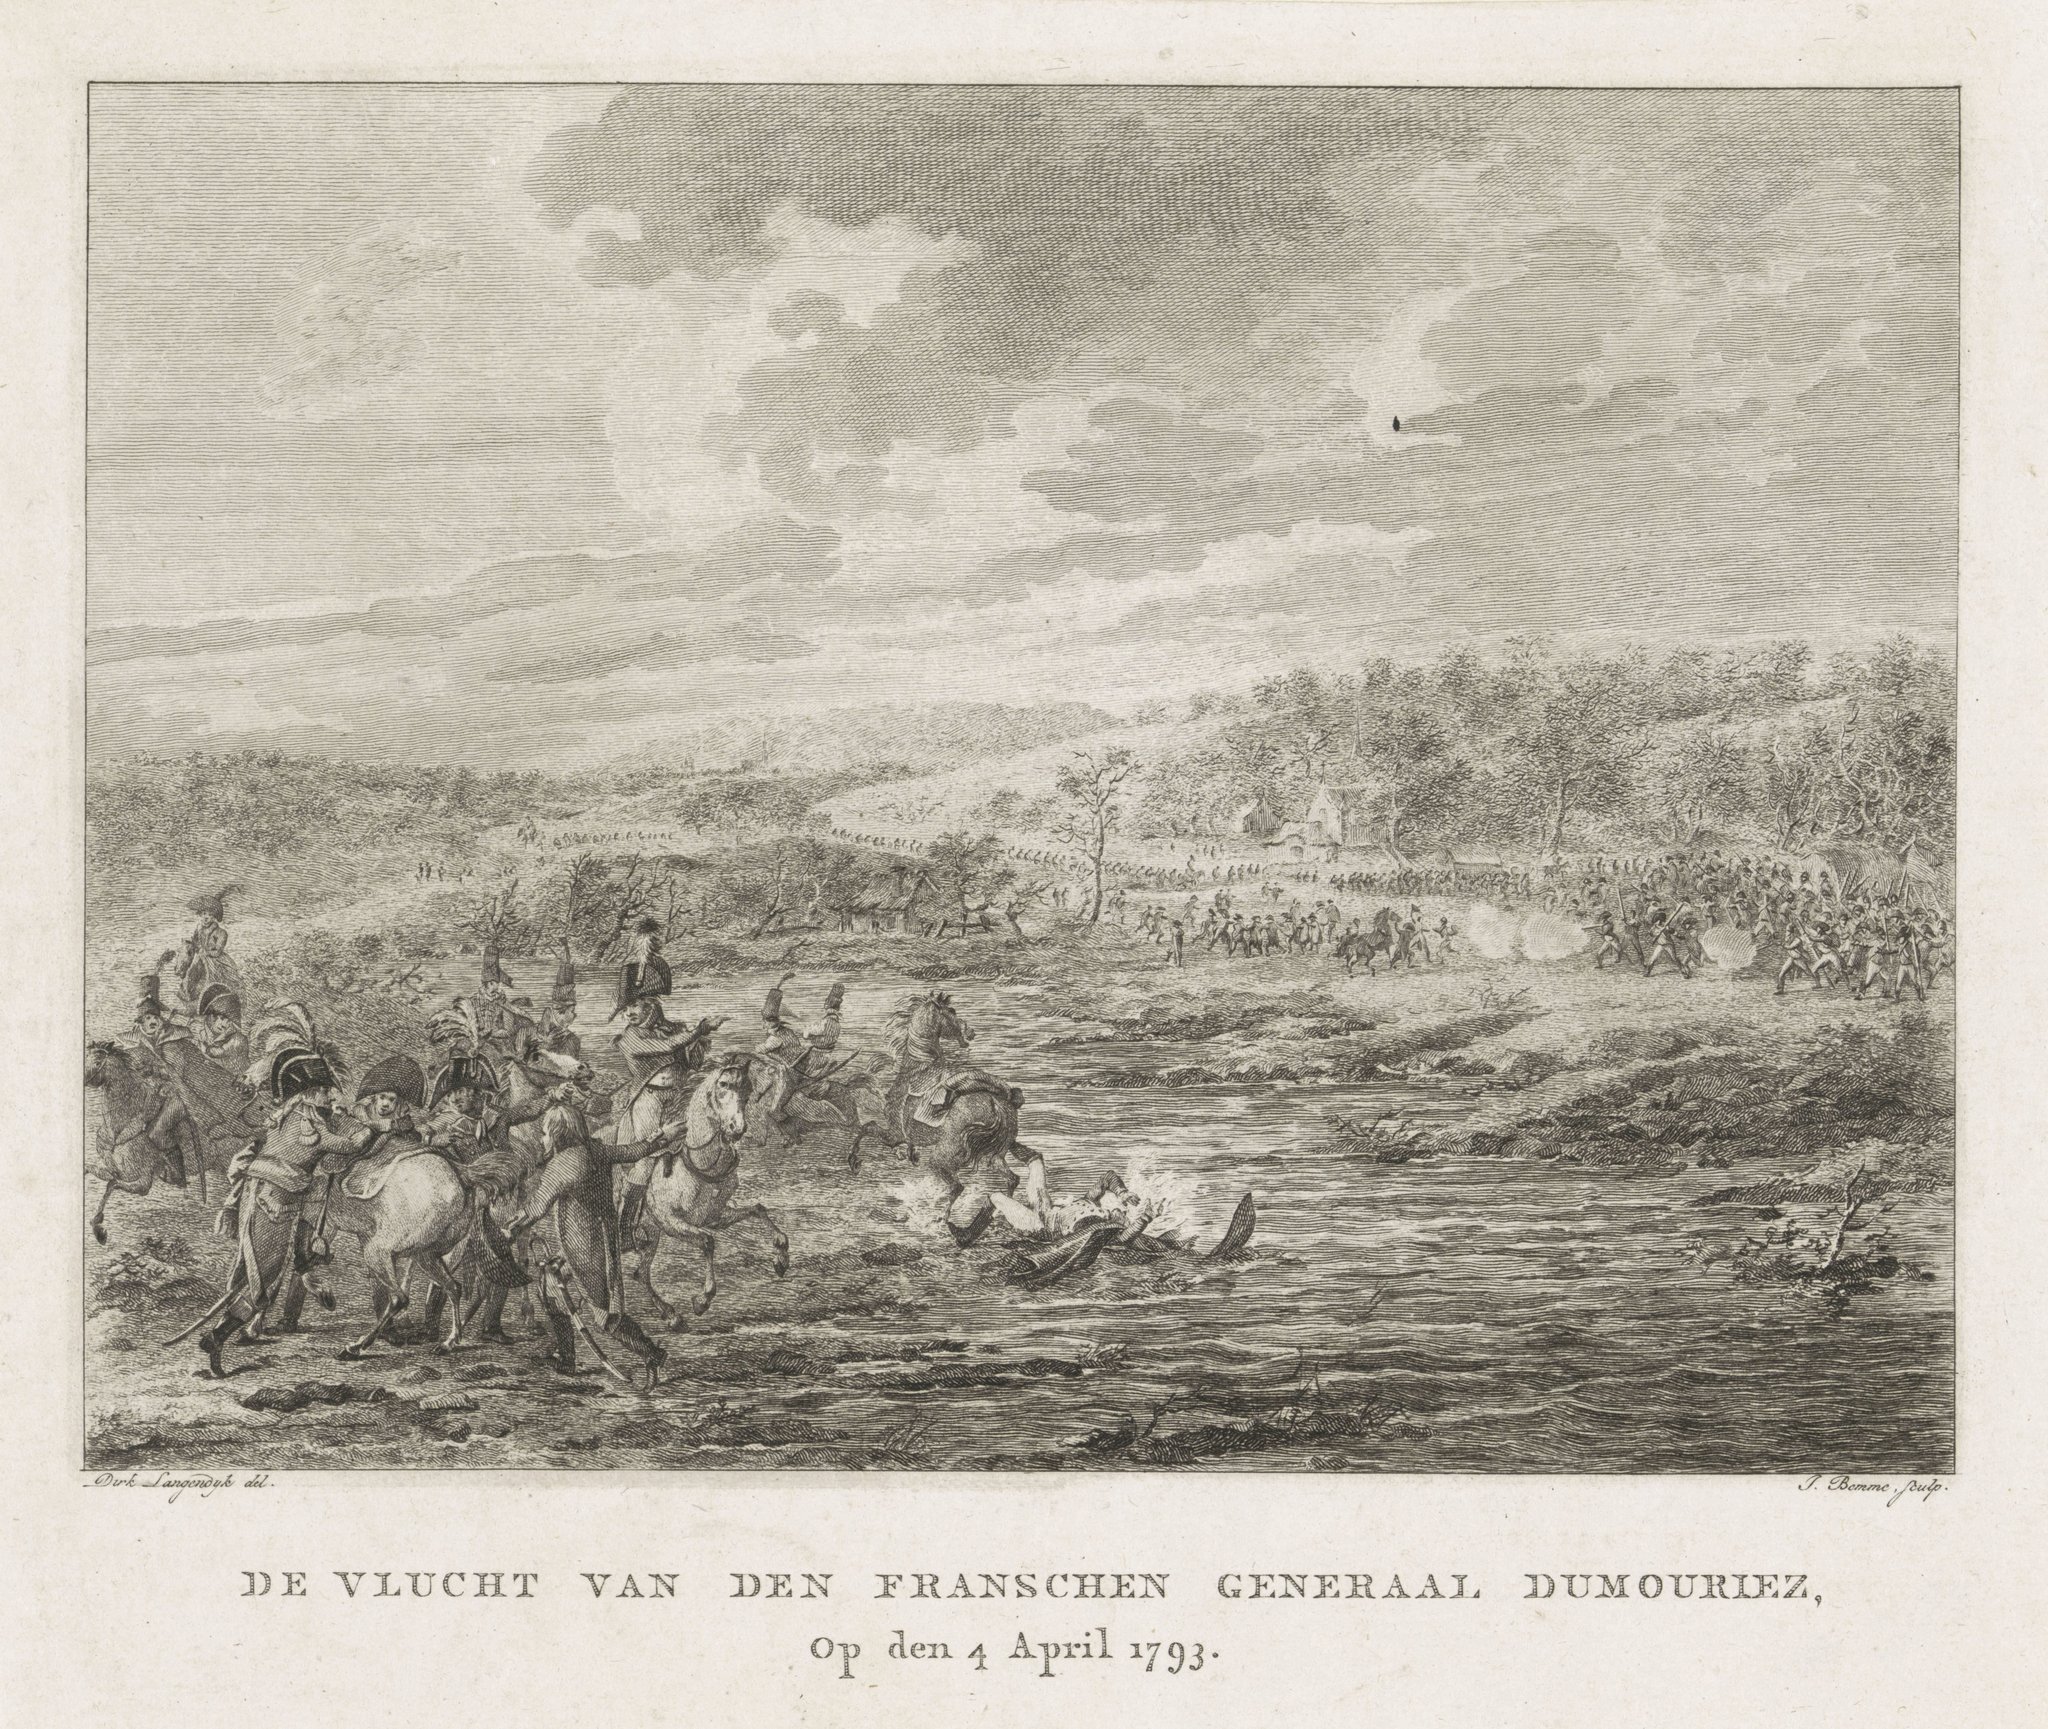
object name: print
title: De vlucht van den Franschen generaal Dumouriez, Op den 4 April 1793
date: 1793-1795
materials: paper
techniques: engraving, etching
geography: northern netherlands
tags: putting the enemy to flight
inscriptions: collector's mark: Lugt 2228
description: Vlucht van de Franse generaal Dumouriez, 4 april 1793. De generaal steekt met een aantal officieren te paard een riviertje over, achterna gezeten en beschoten door een leger aan de overzijde.